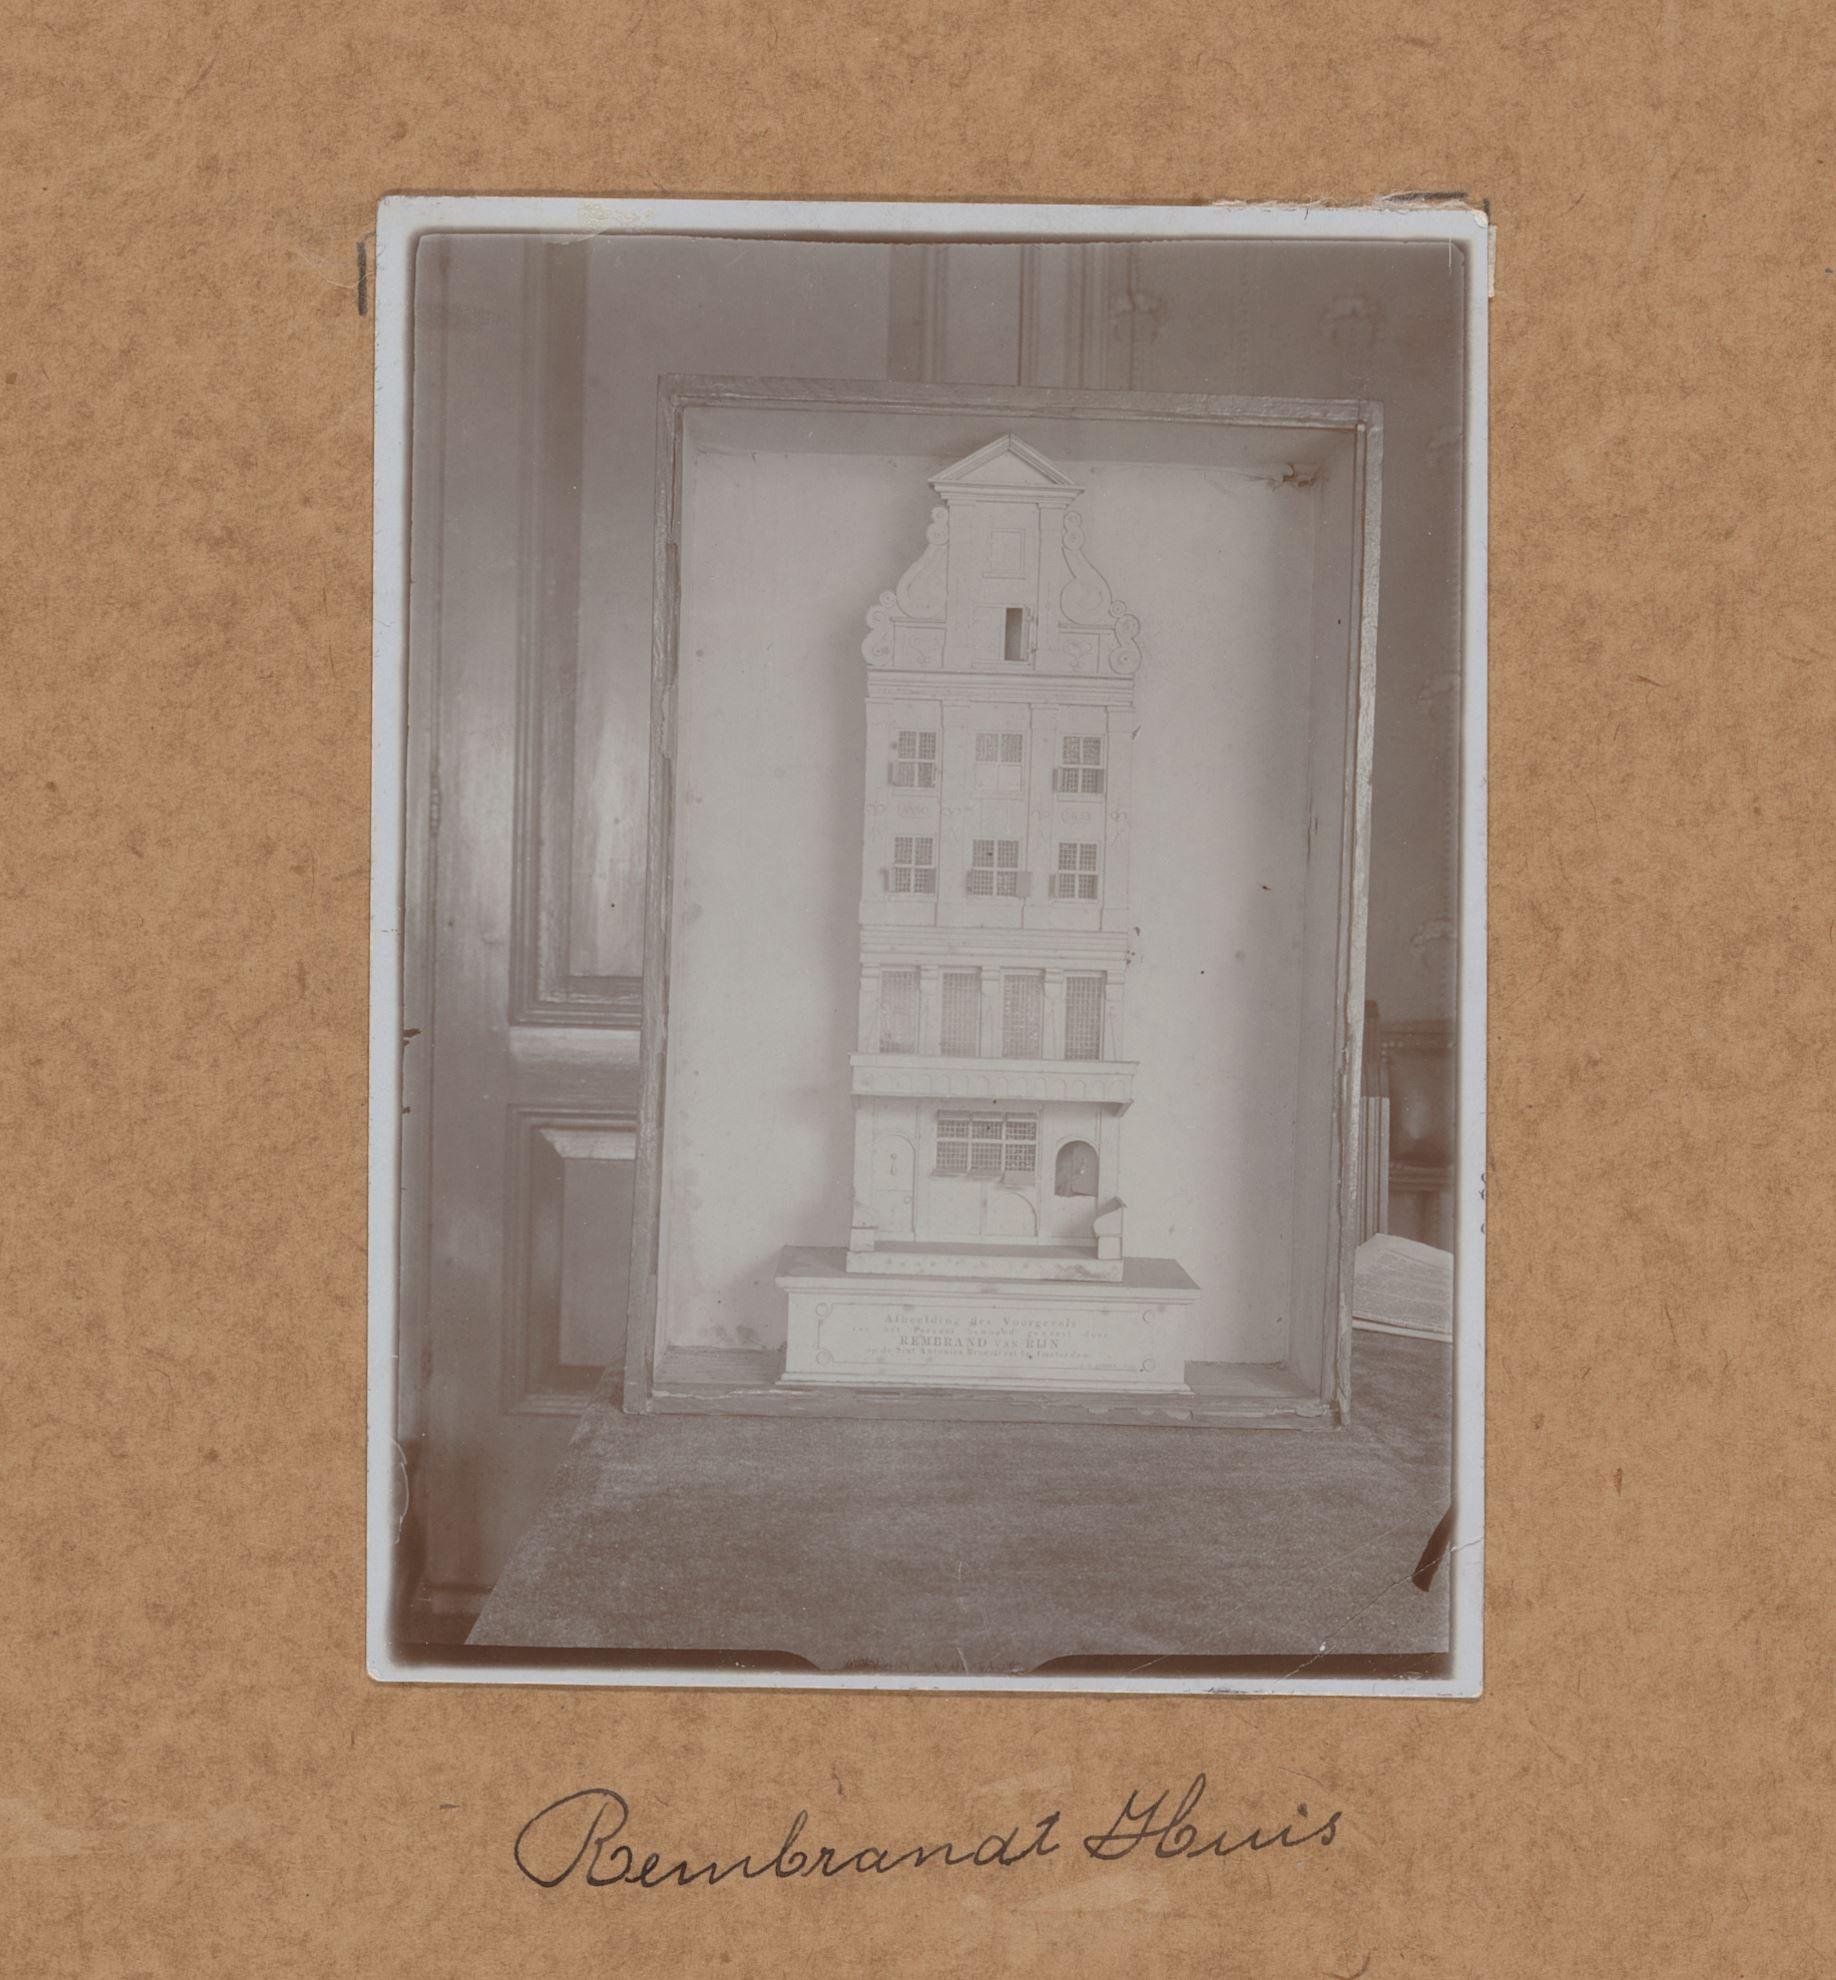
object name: photograph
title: Maquette van Sint Antoniesbreestraat 68 te Amsterdam, het vermeende Rembrandthuis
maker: Anonymous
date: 1890-1910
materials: cardboard, photographic support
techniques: collodion silver print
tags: architectural design or model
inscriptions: annotation: ‘Rembrandt Huis/ Niet R.s huis,/ zie Oud Amsterdam 2, 1950, 164-166/ Amsterdam’, collector's mark: Lugt 2228, annotation: ‘Rembrandthuis’